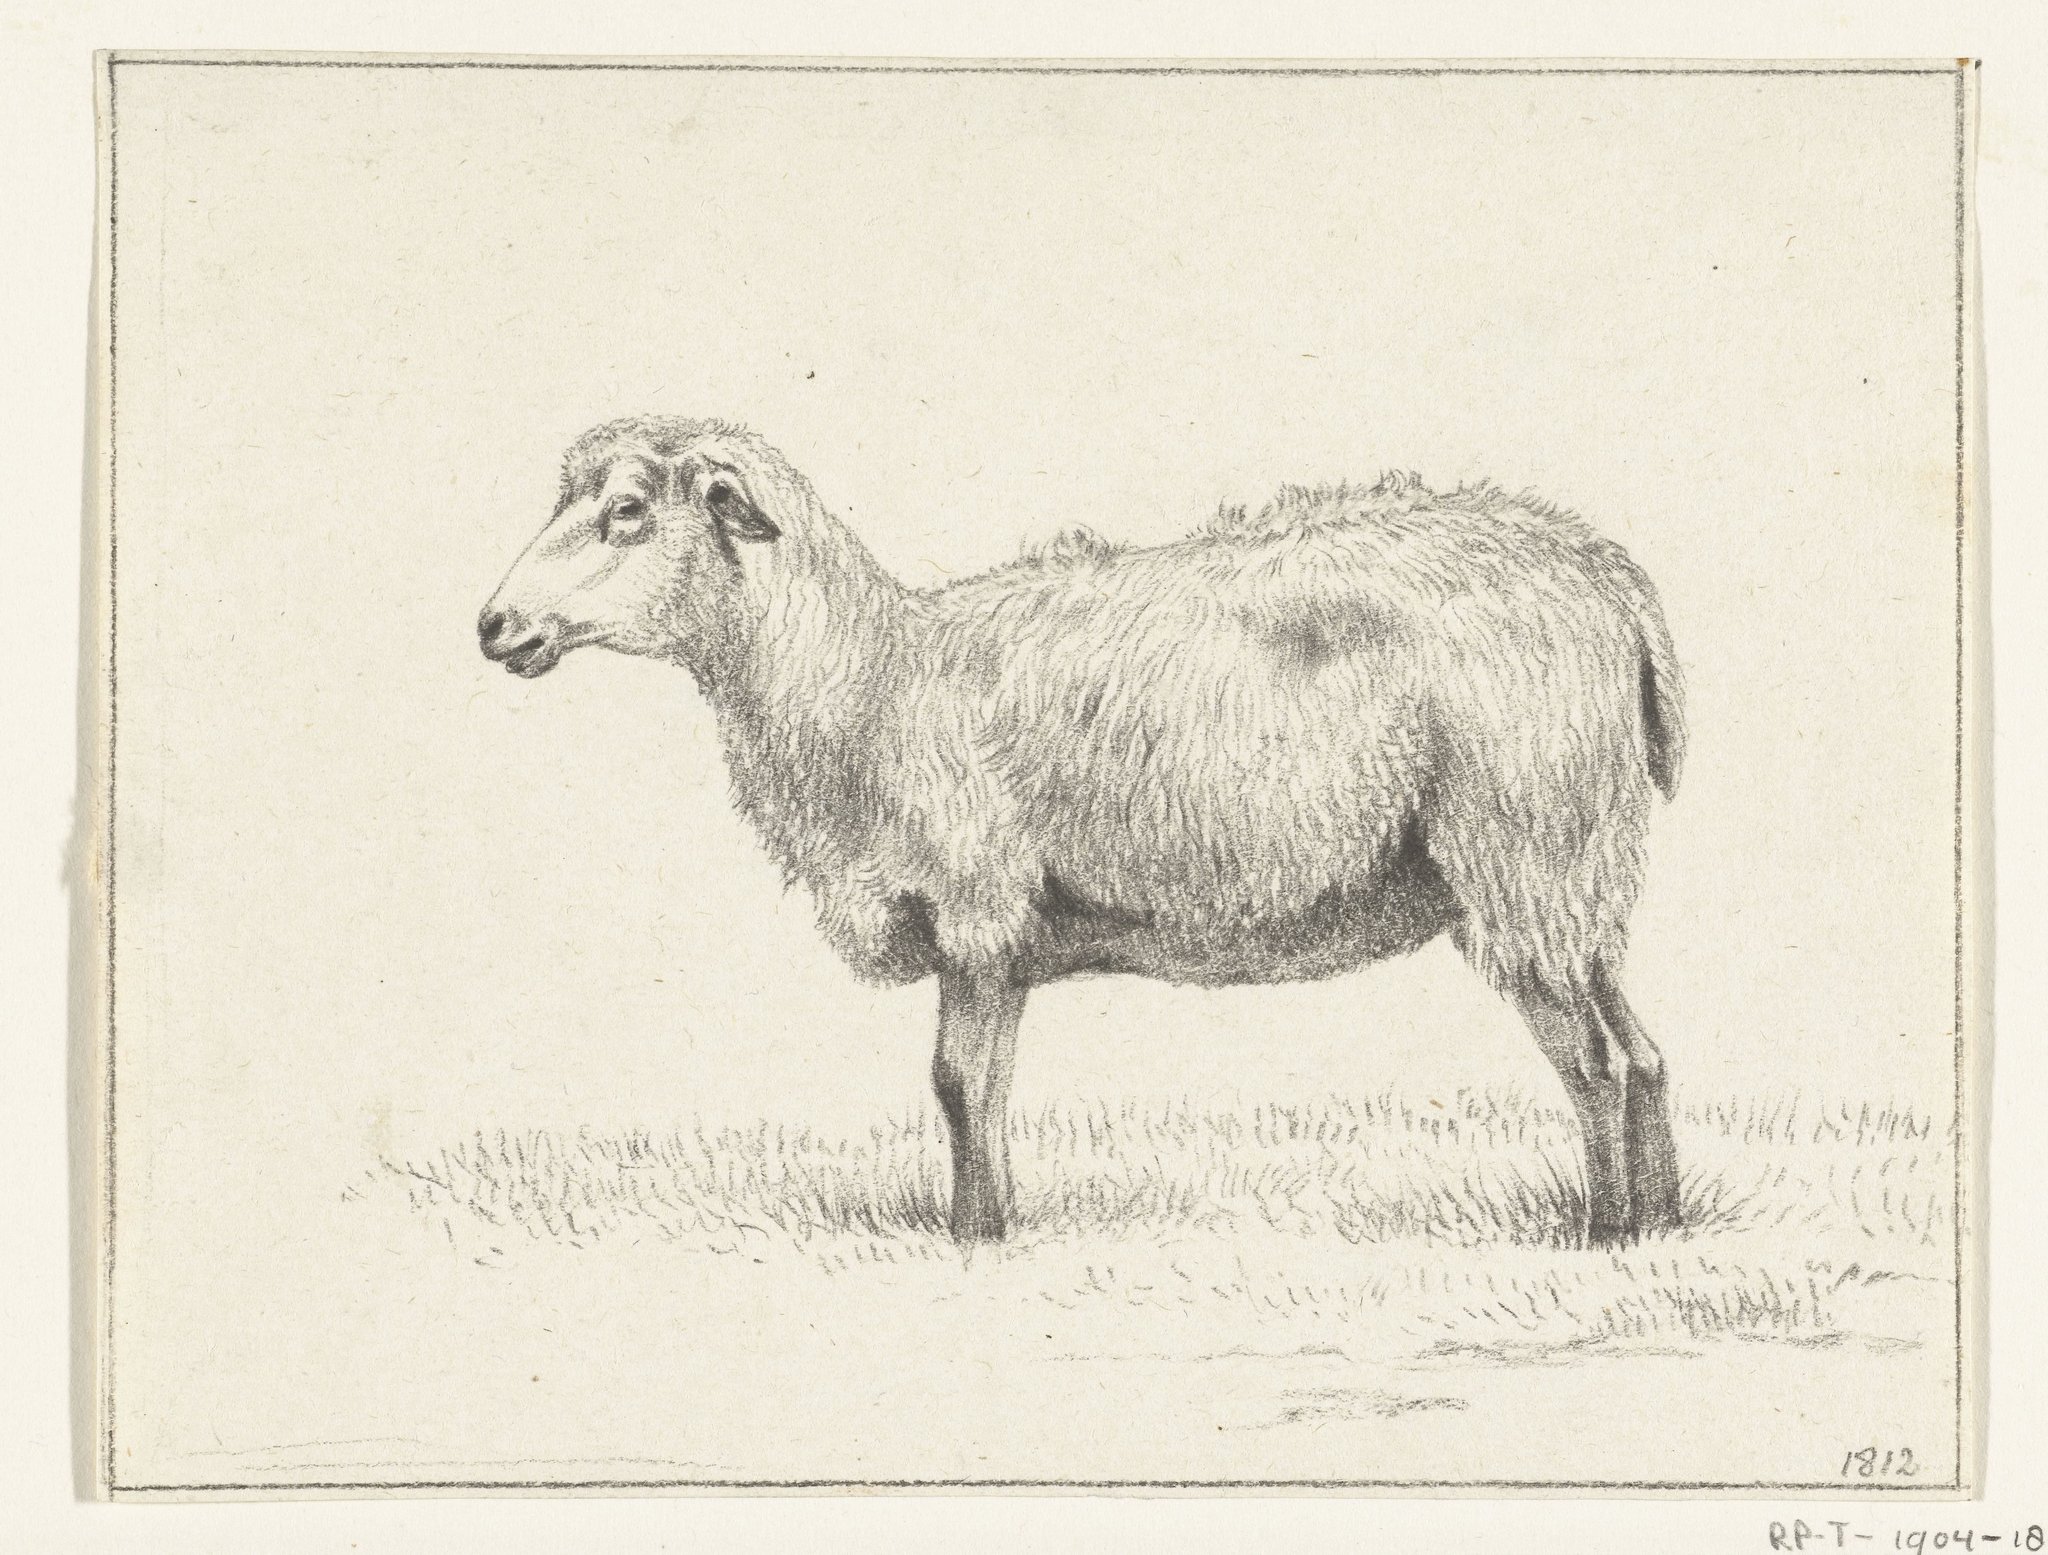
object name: drawing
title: Staand schaap, naar links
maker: jean bernard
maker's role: draughtsman, print maker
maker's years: 1765-1833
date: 1812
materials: chalk, paper, pencil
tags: sheep